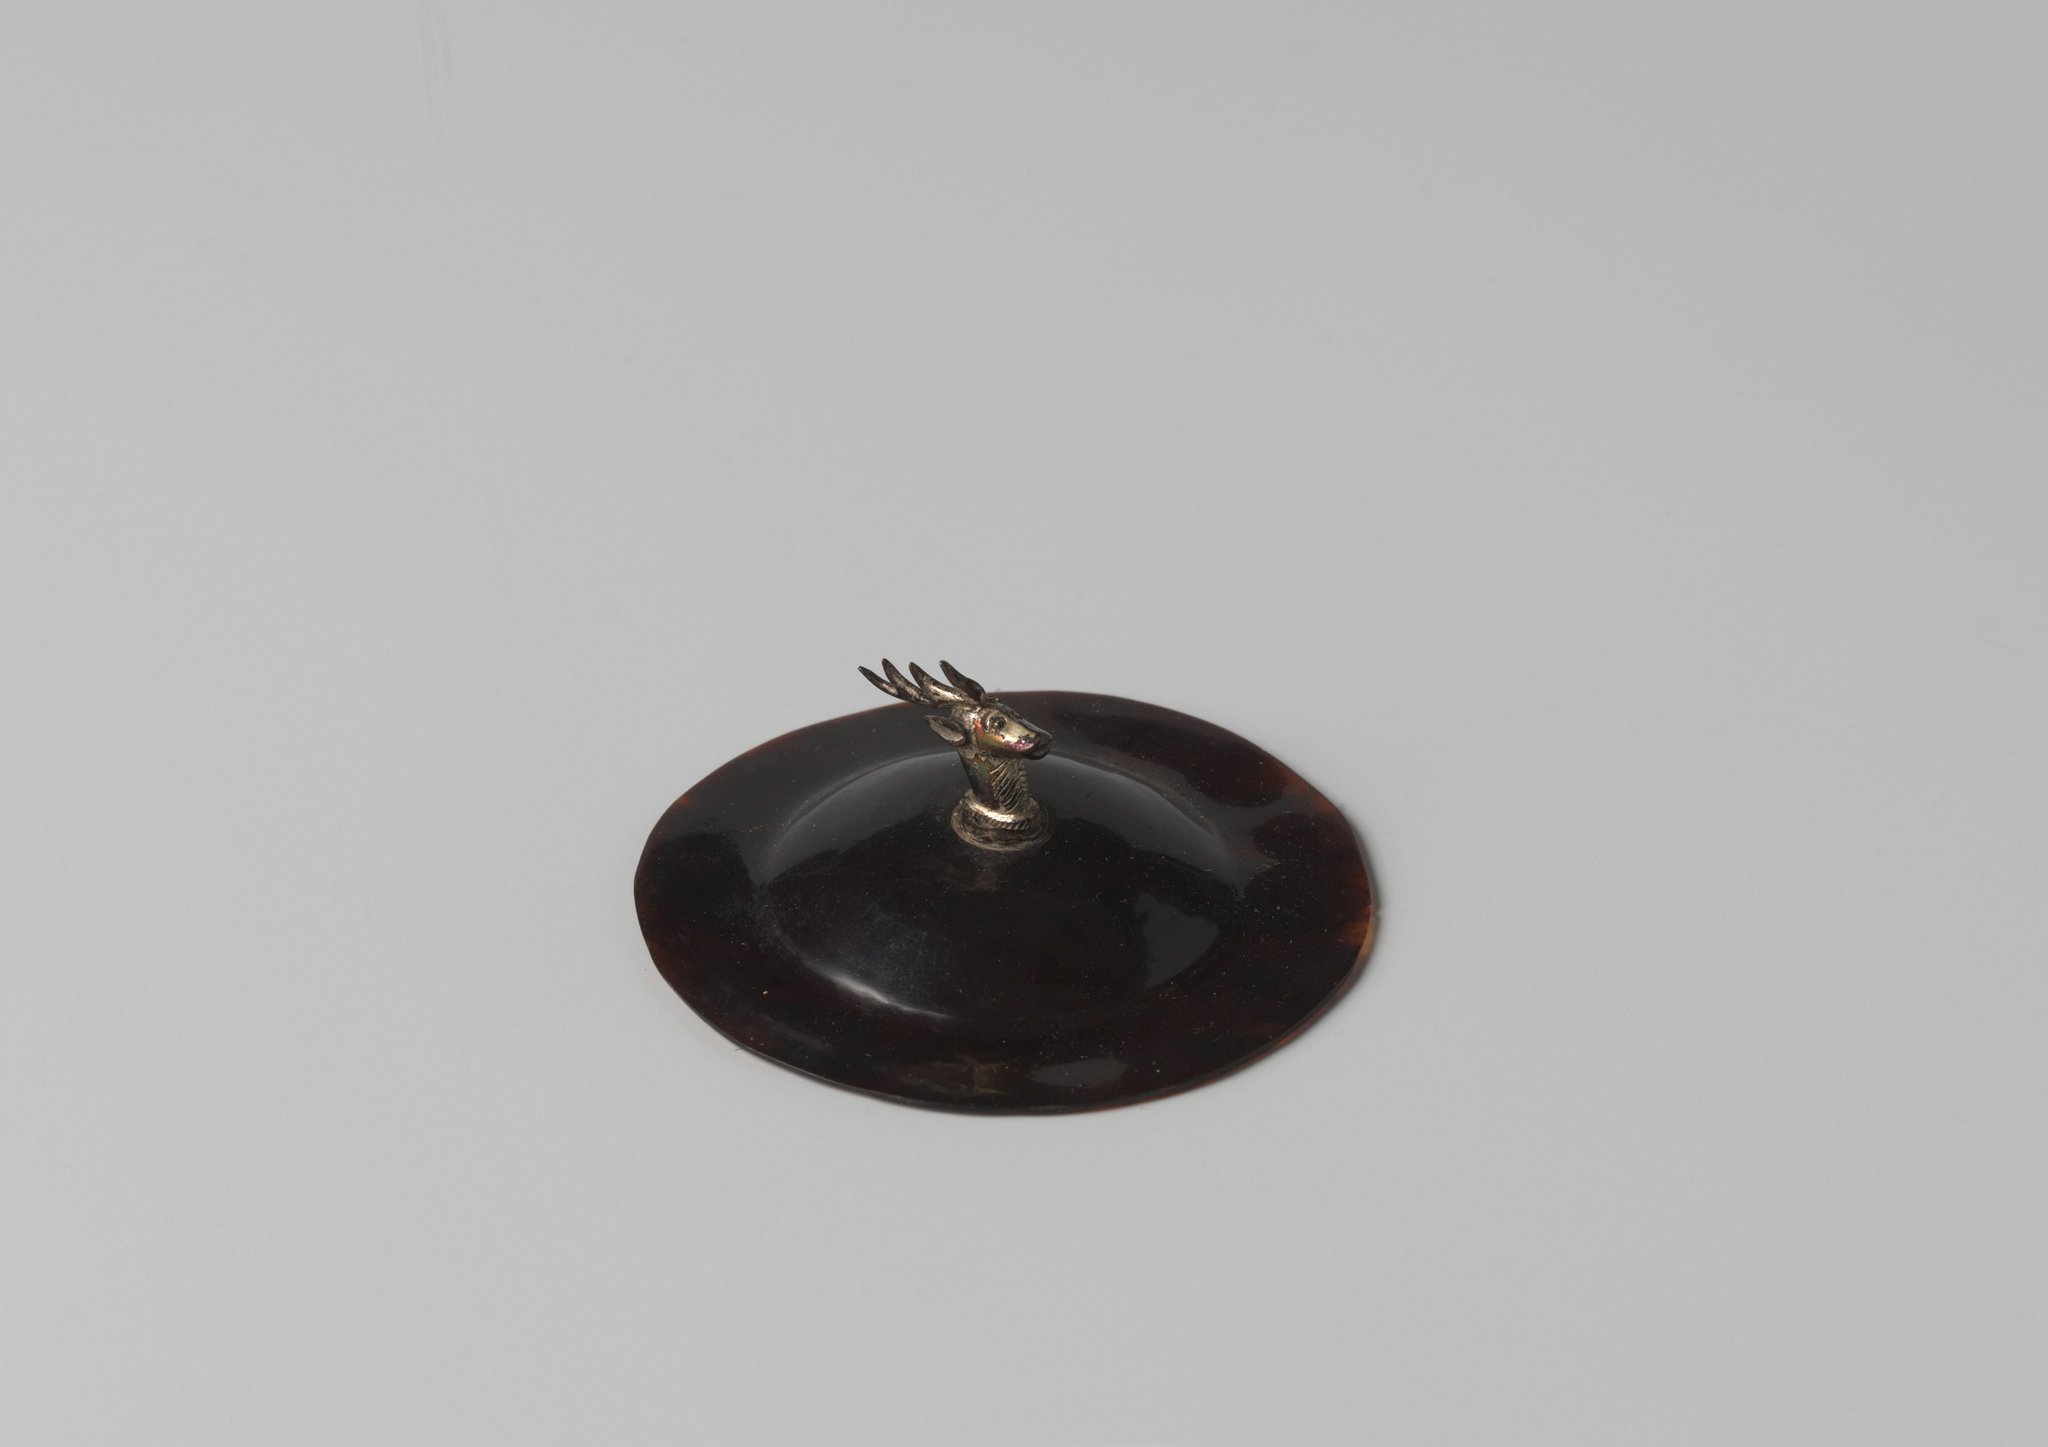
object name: lid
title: Deksel van schildpad met hertekop van zilver (serie van 28 stuks A t/m BB)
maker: Anonymous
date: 1700-1799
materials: silver, shell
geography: indonesia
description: Deksel van schildpad met hertekop van zilver (serie van 28 stuks A t/m BB), Indonesië, 18de eeuw?